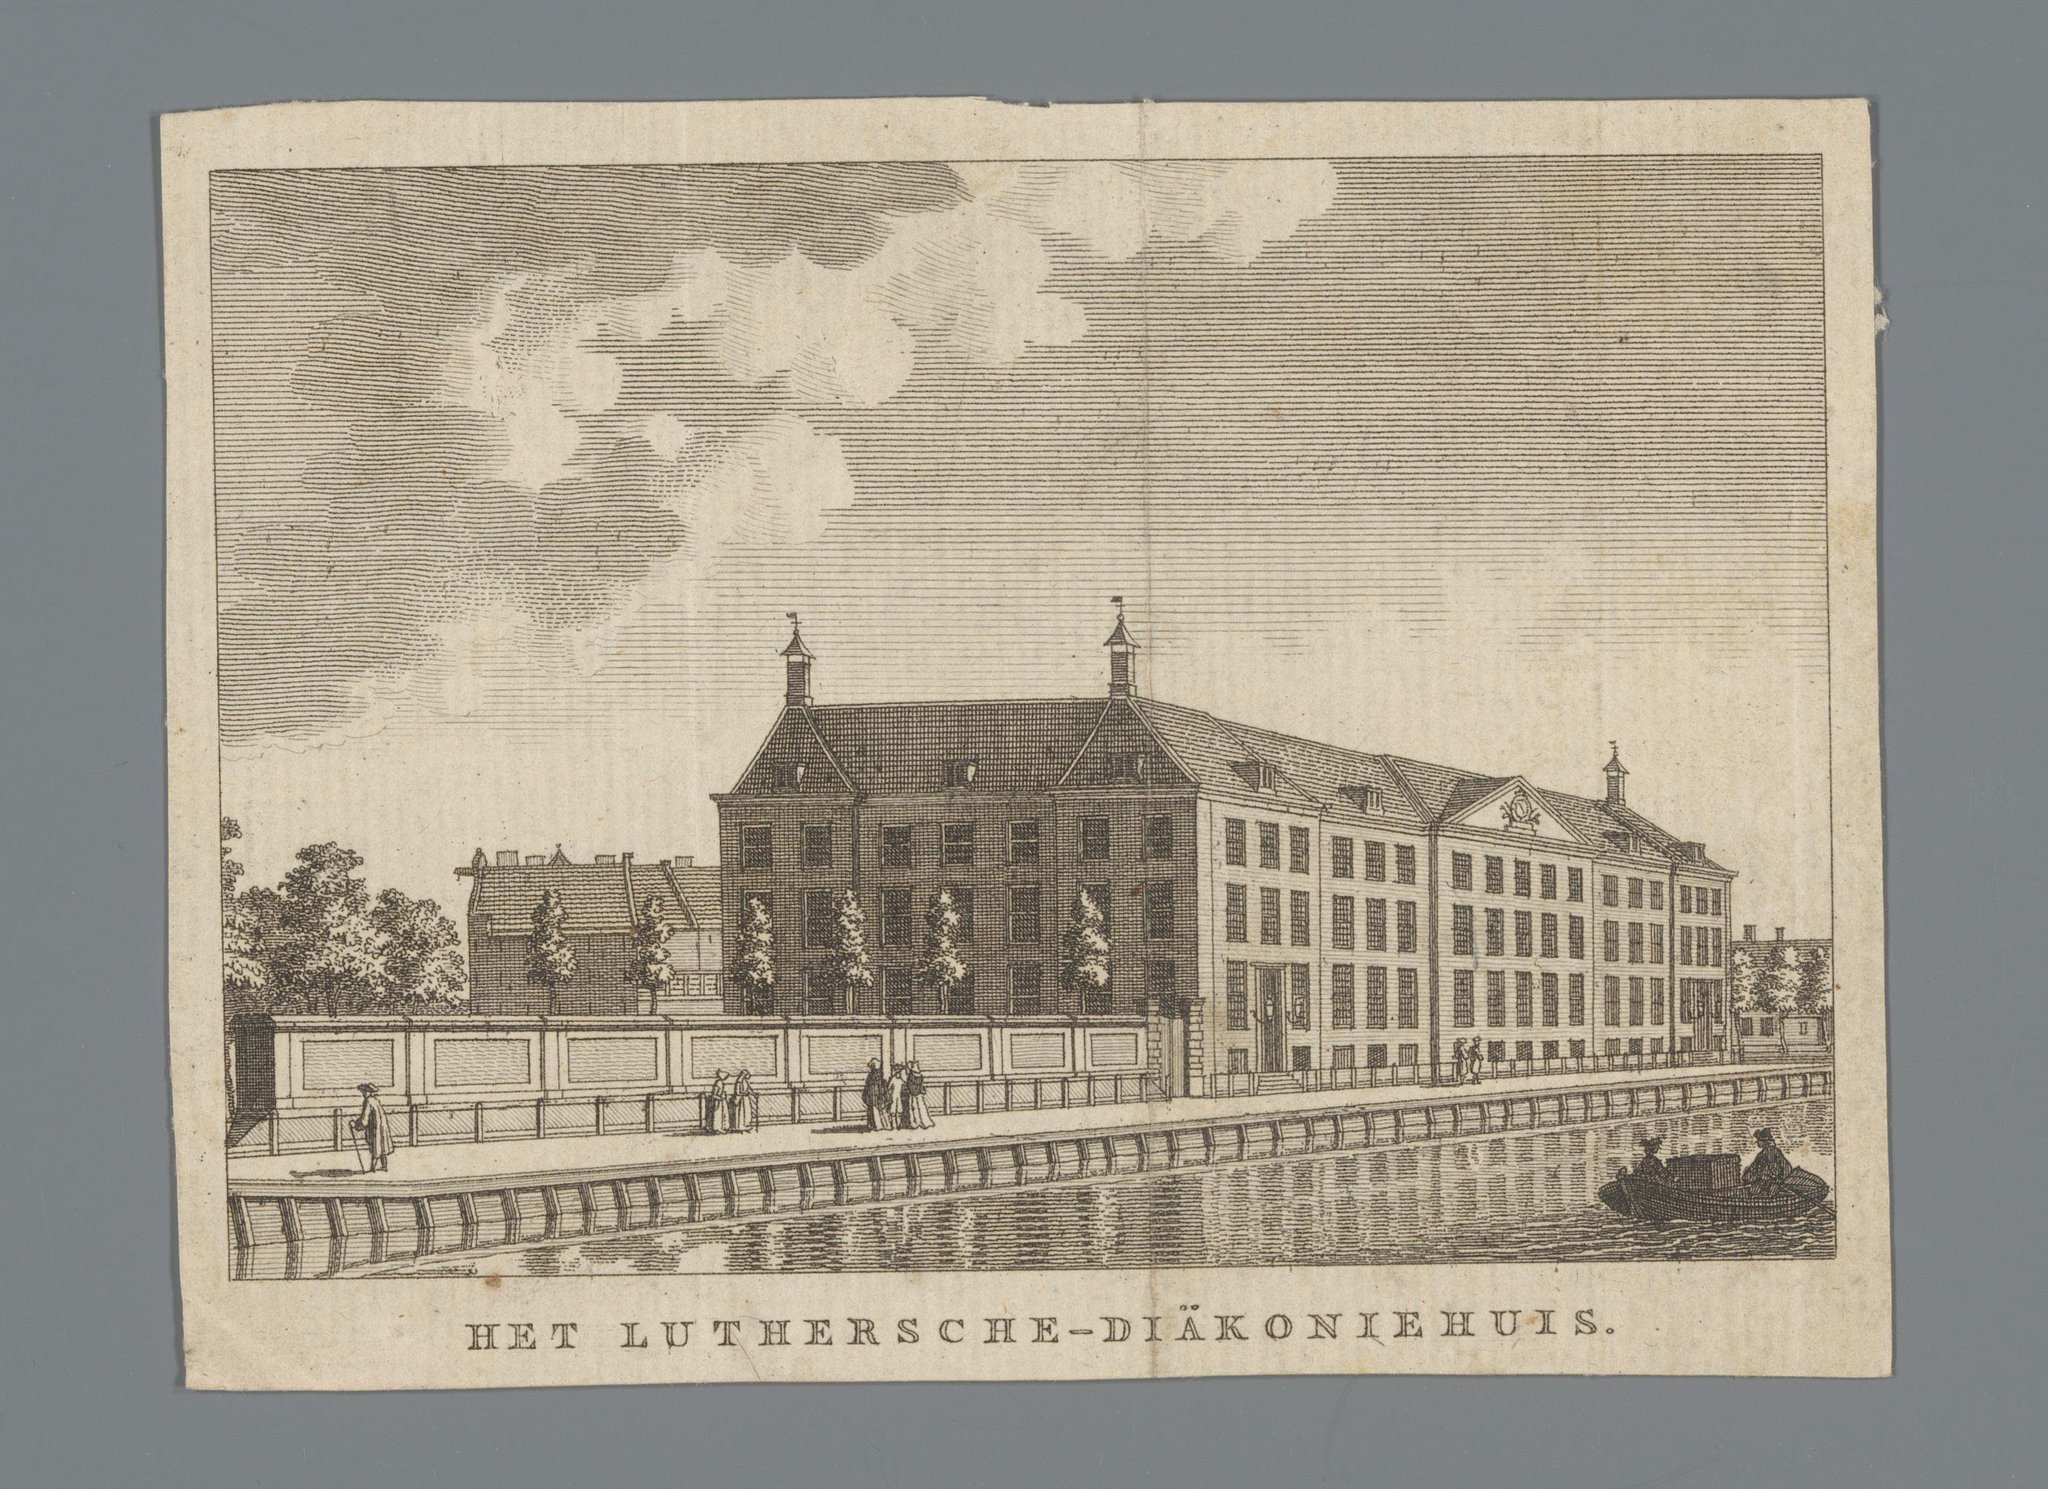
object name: print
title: Gezicht op het Lutherse Diaconiehuis te Amsterdam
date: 1789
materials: paper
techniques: etching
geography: amsterdam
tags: public welfare, canals, waters (in city), exterior ~ representation of a building, street (+ city(-scape) with figures, staffage)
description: Prent uit: Amsteldam en zyne geschiedenissen, in 't kort. Amsterdam: Johannes Allart, 1789, dl. 3, tussen p. 218 en 219.